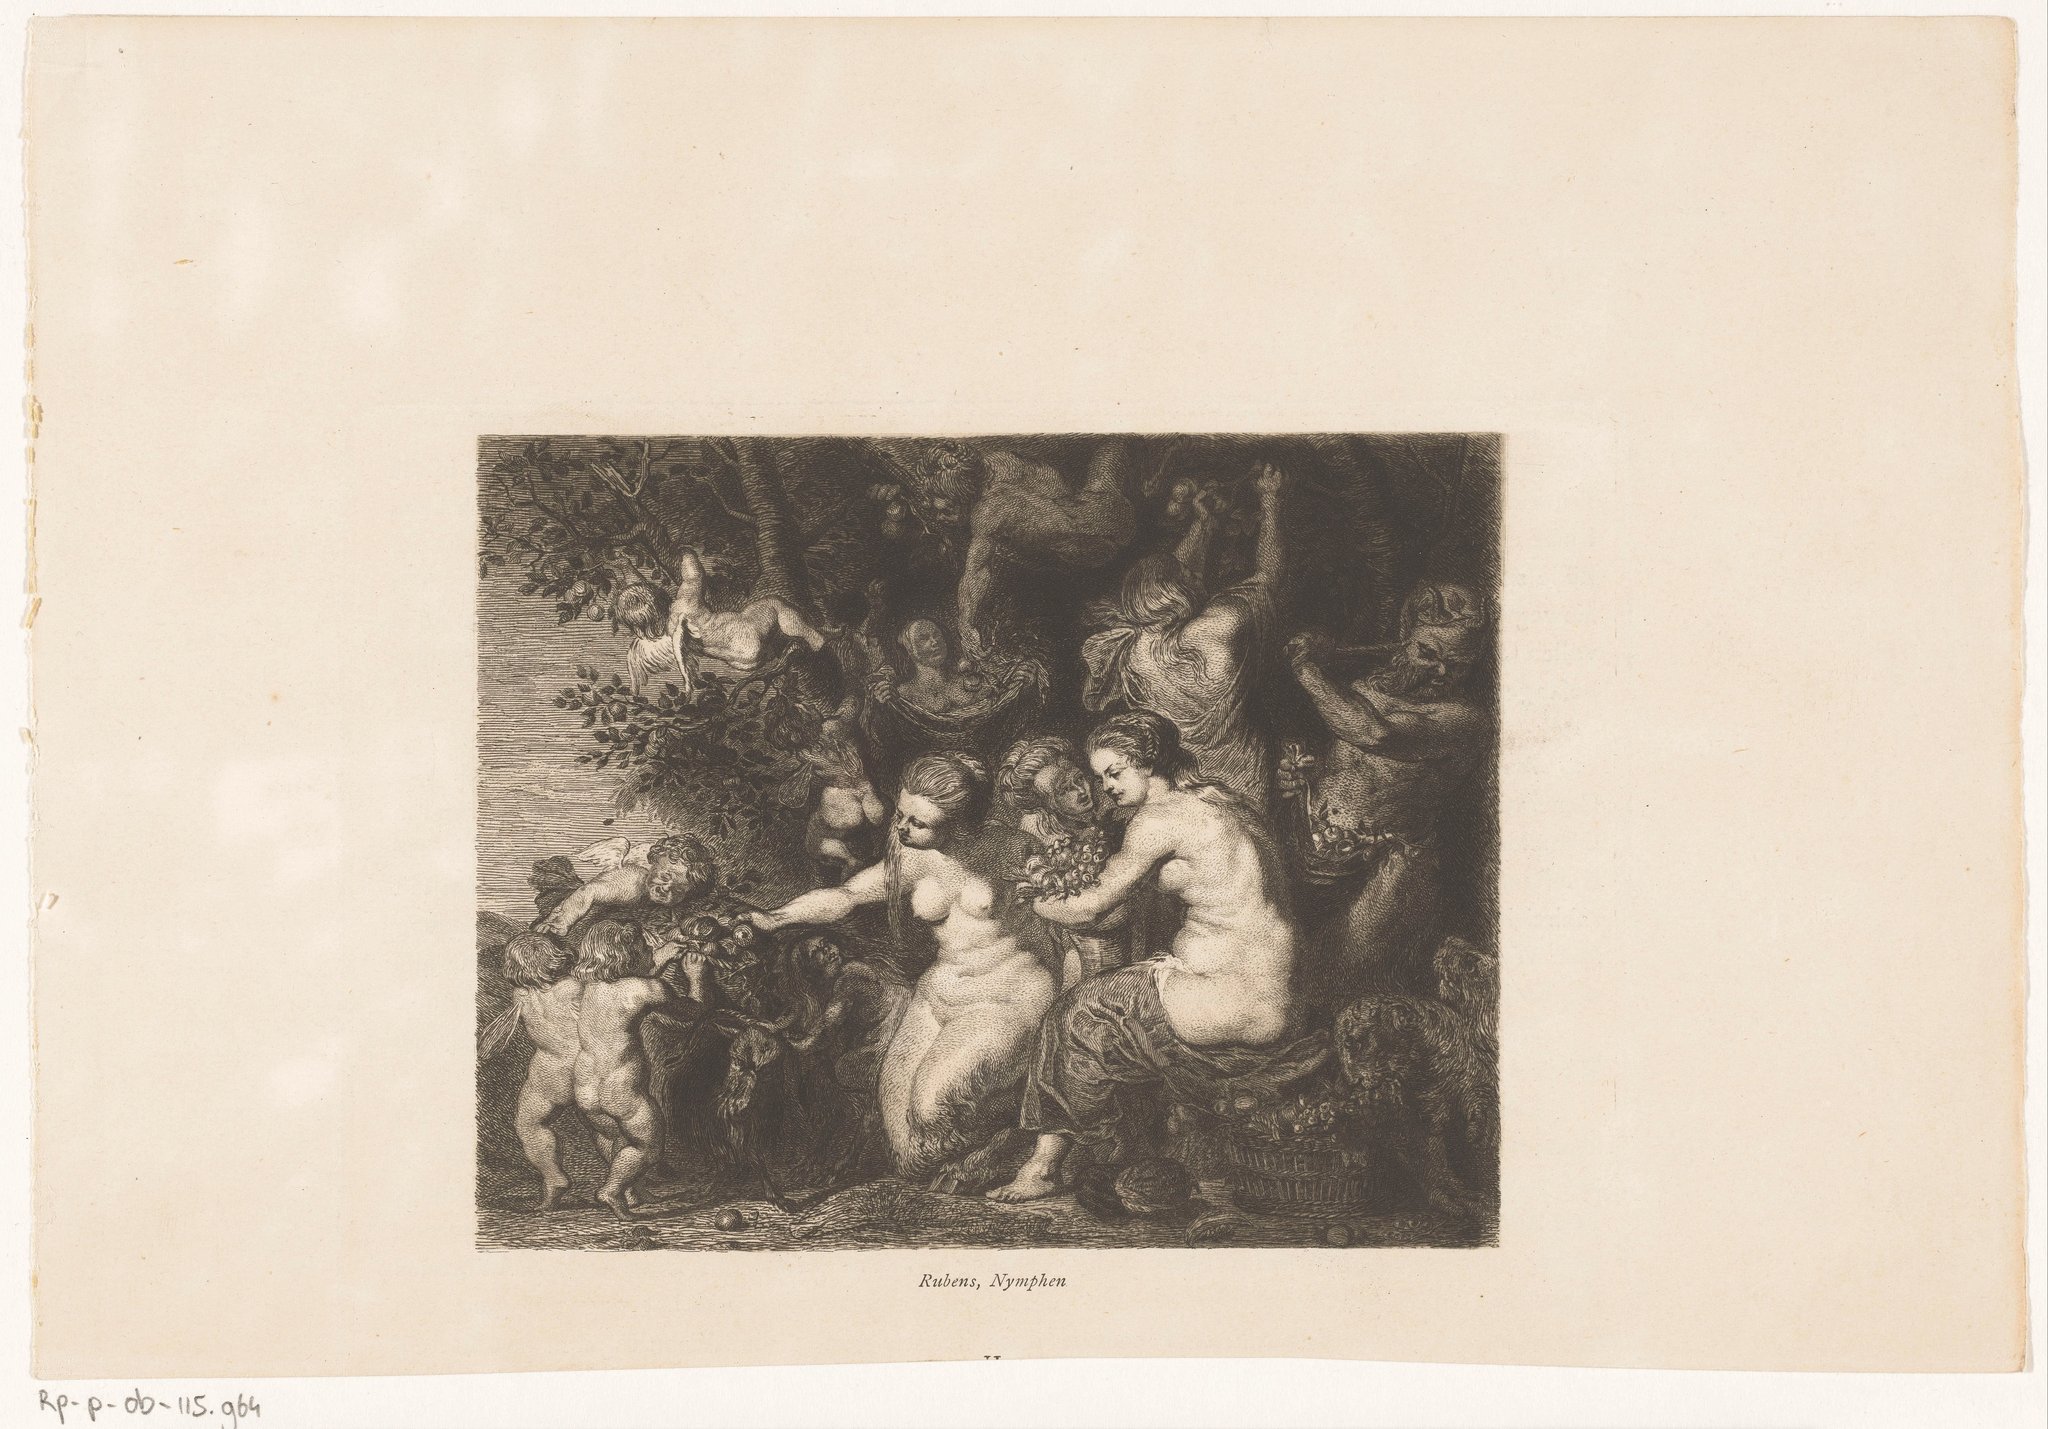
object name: print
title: Nimfen, saters en putti tussen de bomen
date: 1844-1911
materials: paper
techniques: etching, letterpress printing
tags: 'cornucopia', horn of plenty, nymphs (in general); 'ninfe in commune' (ripa), satyr(s) (in general), cupids: 'amores', 'amoretti', 'putti'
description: Mogelijk vervaardigd voor het tijdschrift: Gesellschaft für Vervielfältigende Kunst. Die Graphischen Künste. Wenen: Rudolf Rohrer, 1871-1934.